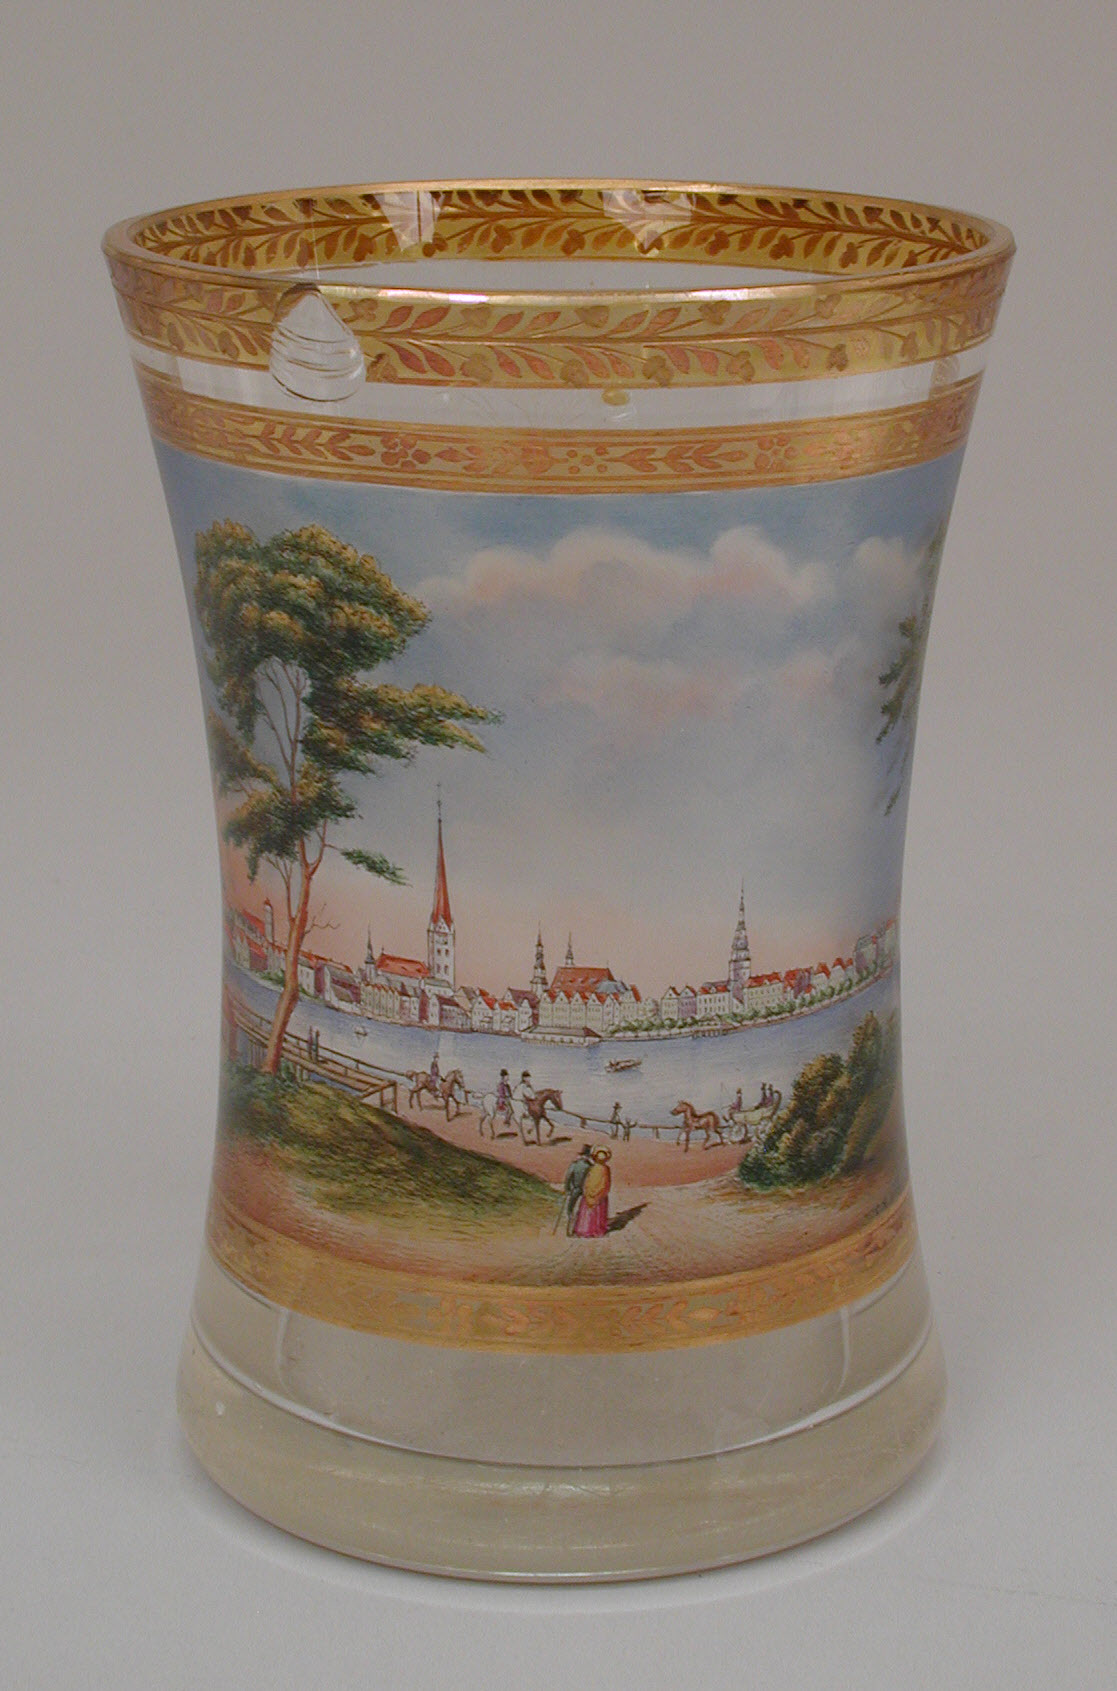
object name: beaker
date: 1830-1840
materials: glass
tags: cities,horses